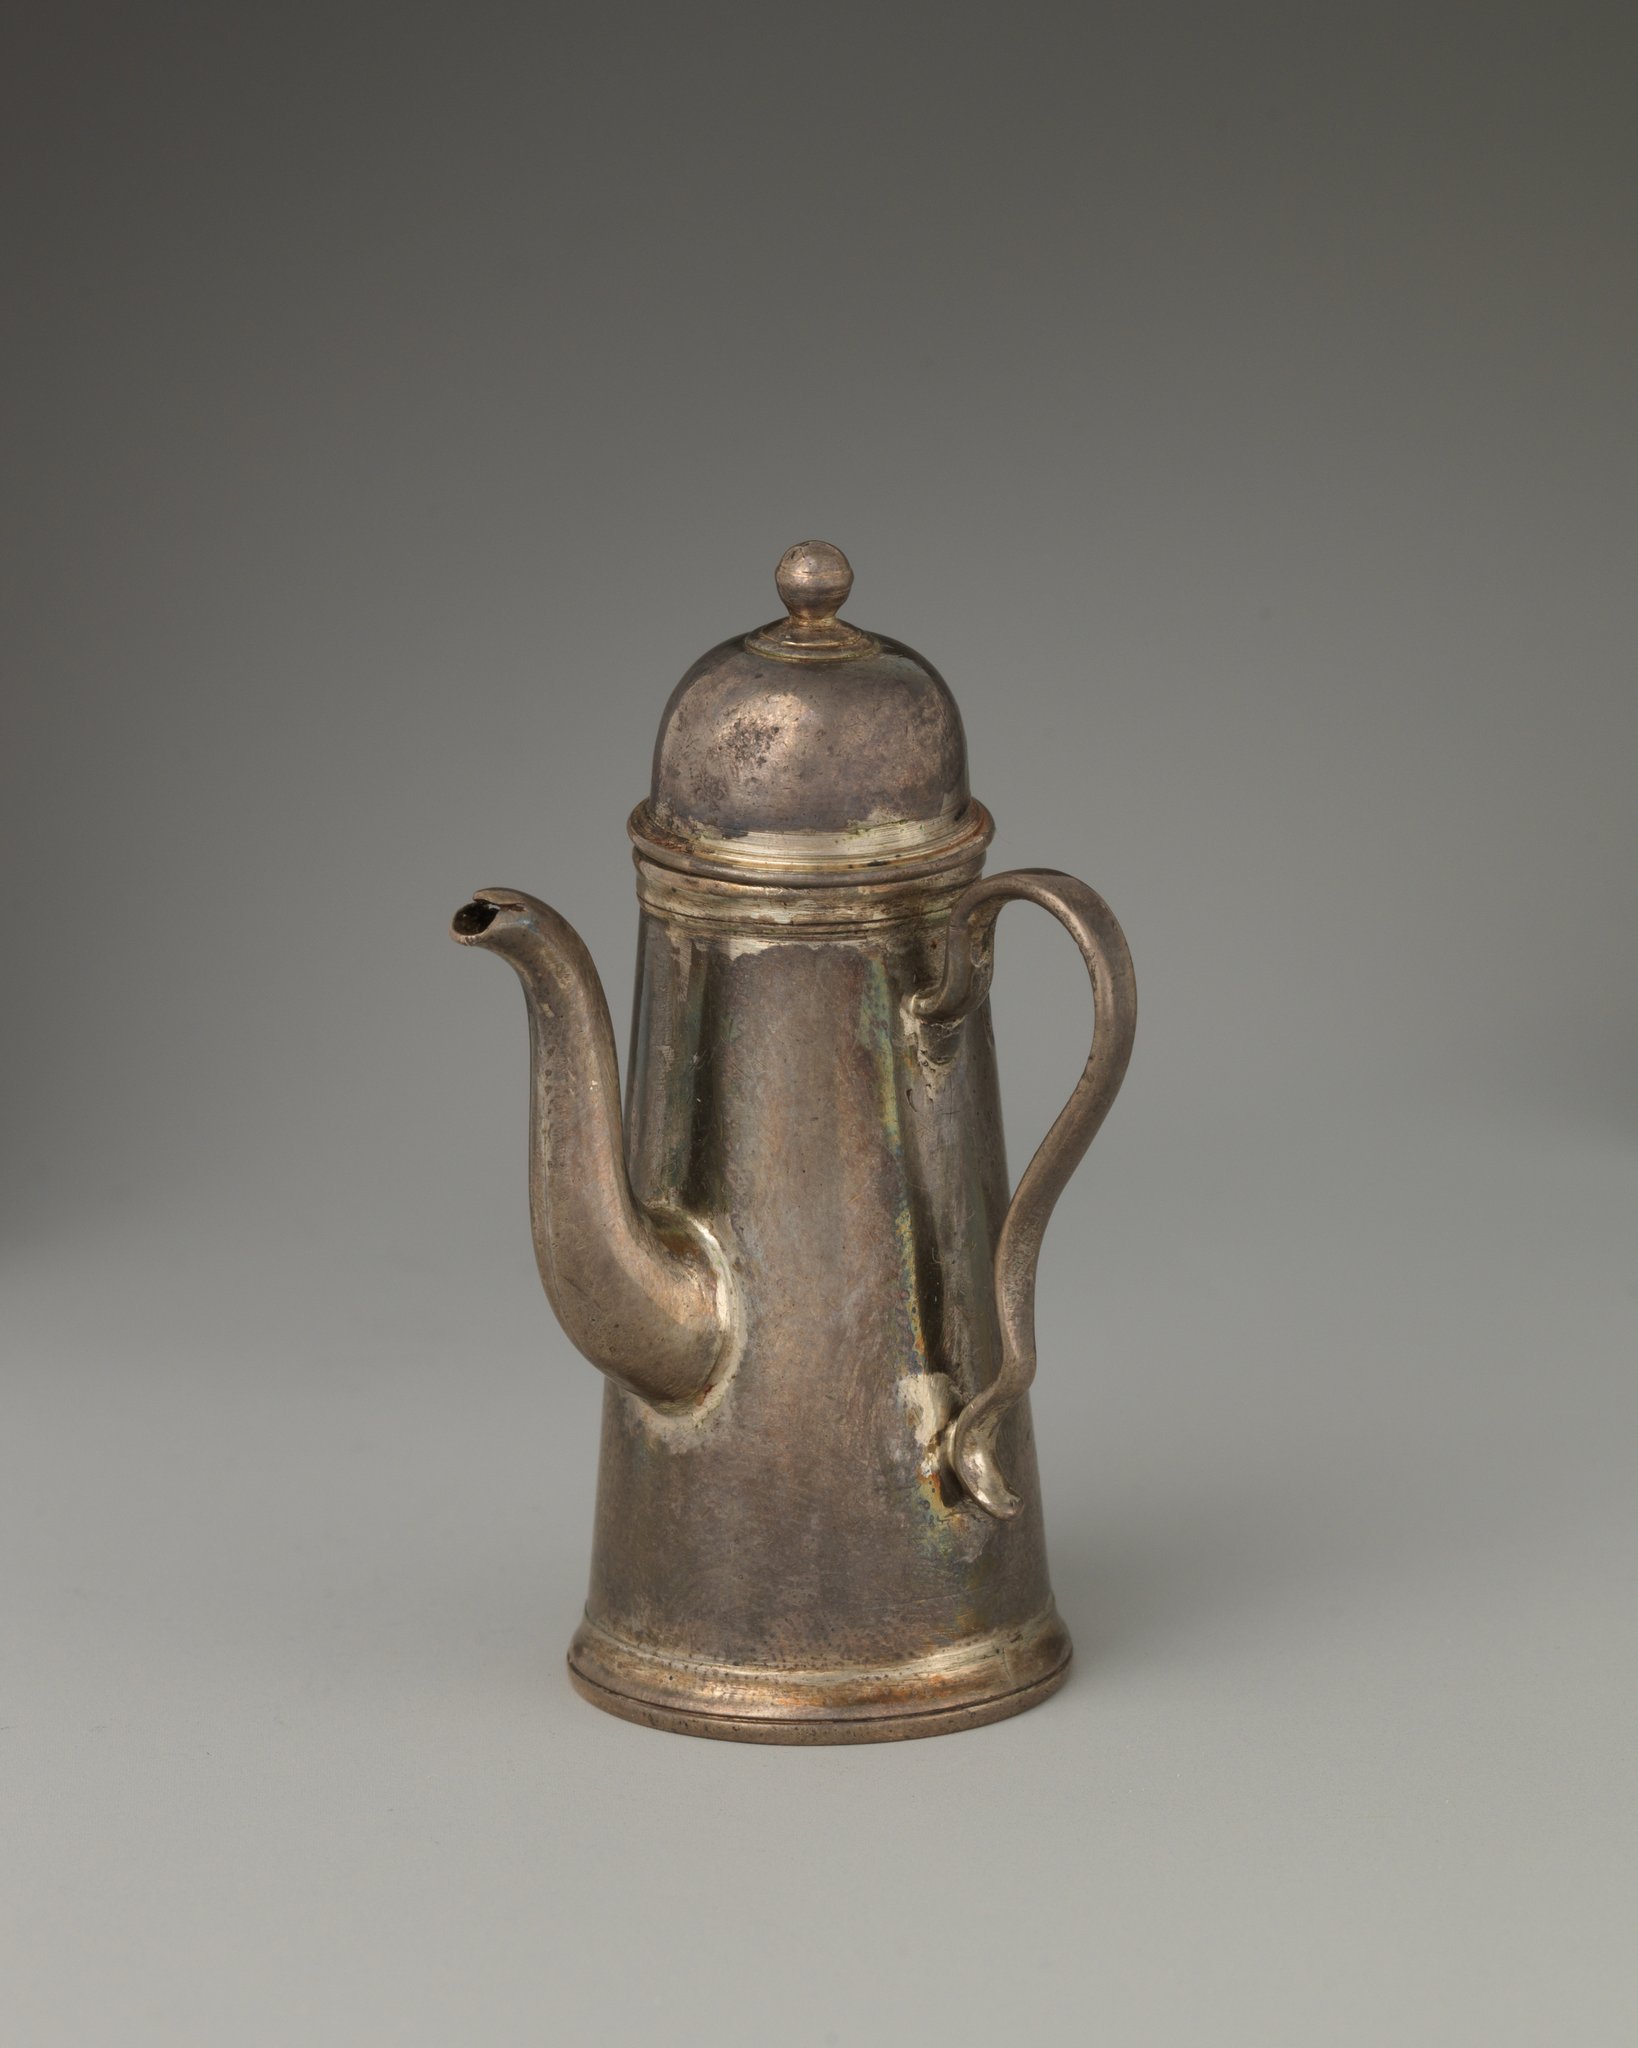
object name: coffeepot with cover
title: Miniature coffeepot with cover (part of a set)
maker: david clayton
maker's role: maker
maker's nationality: british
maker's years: 1659-1719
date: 1667-1733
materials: silver